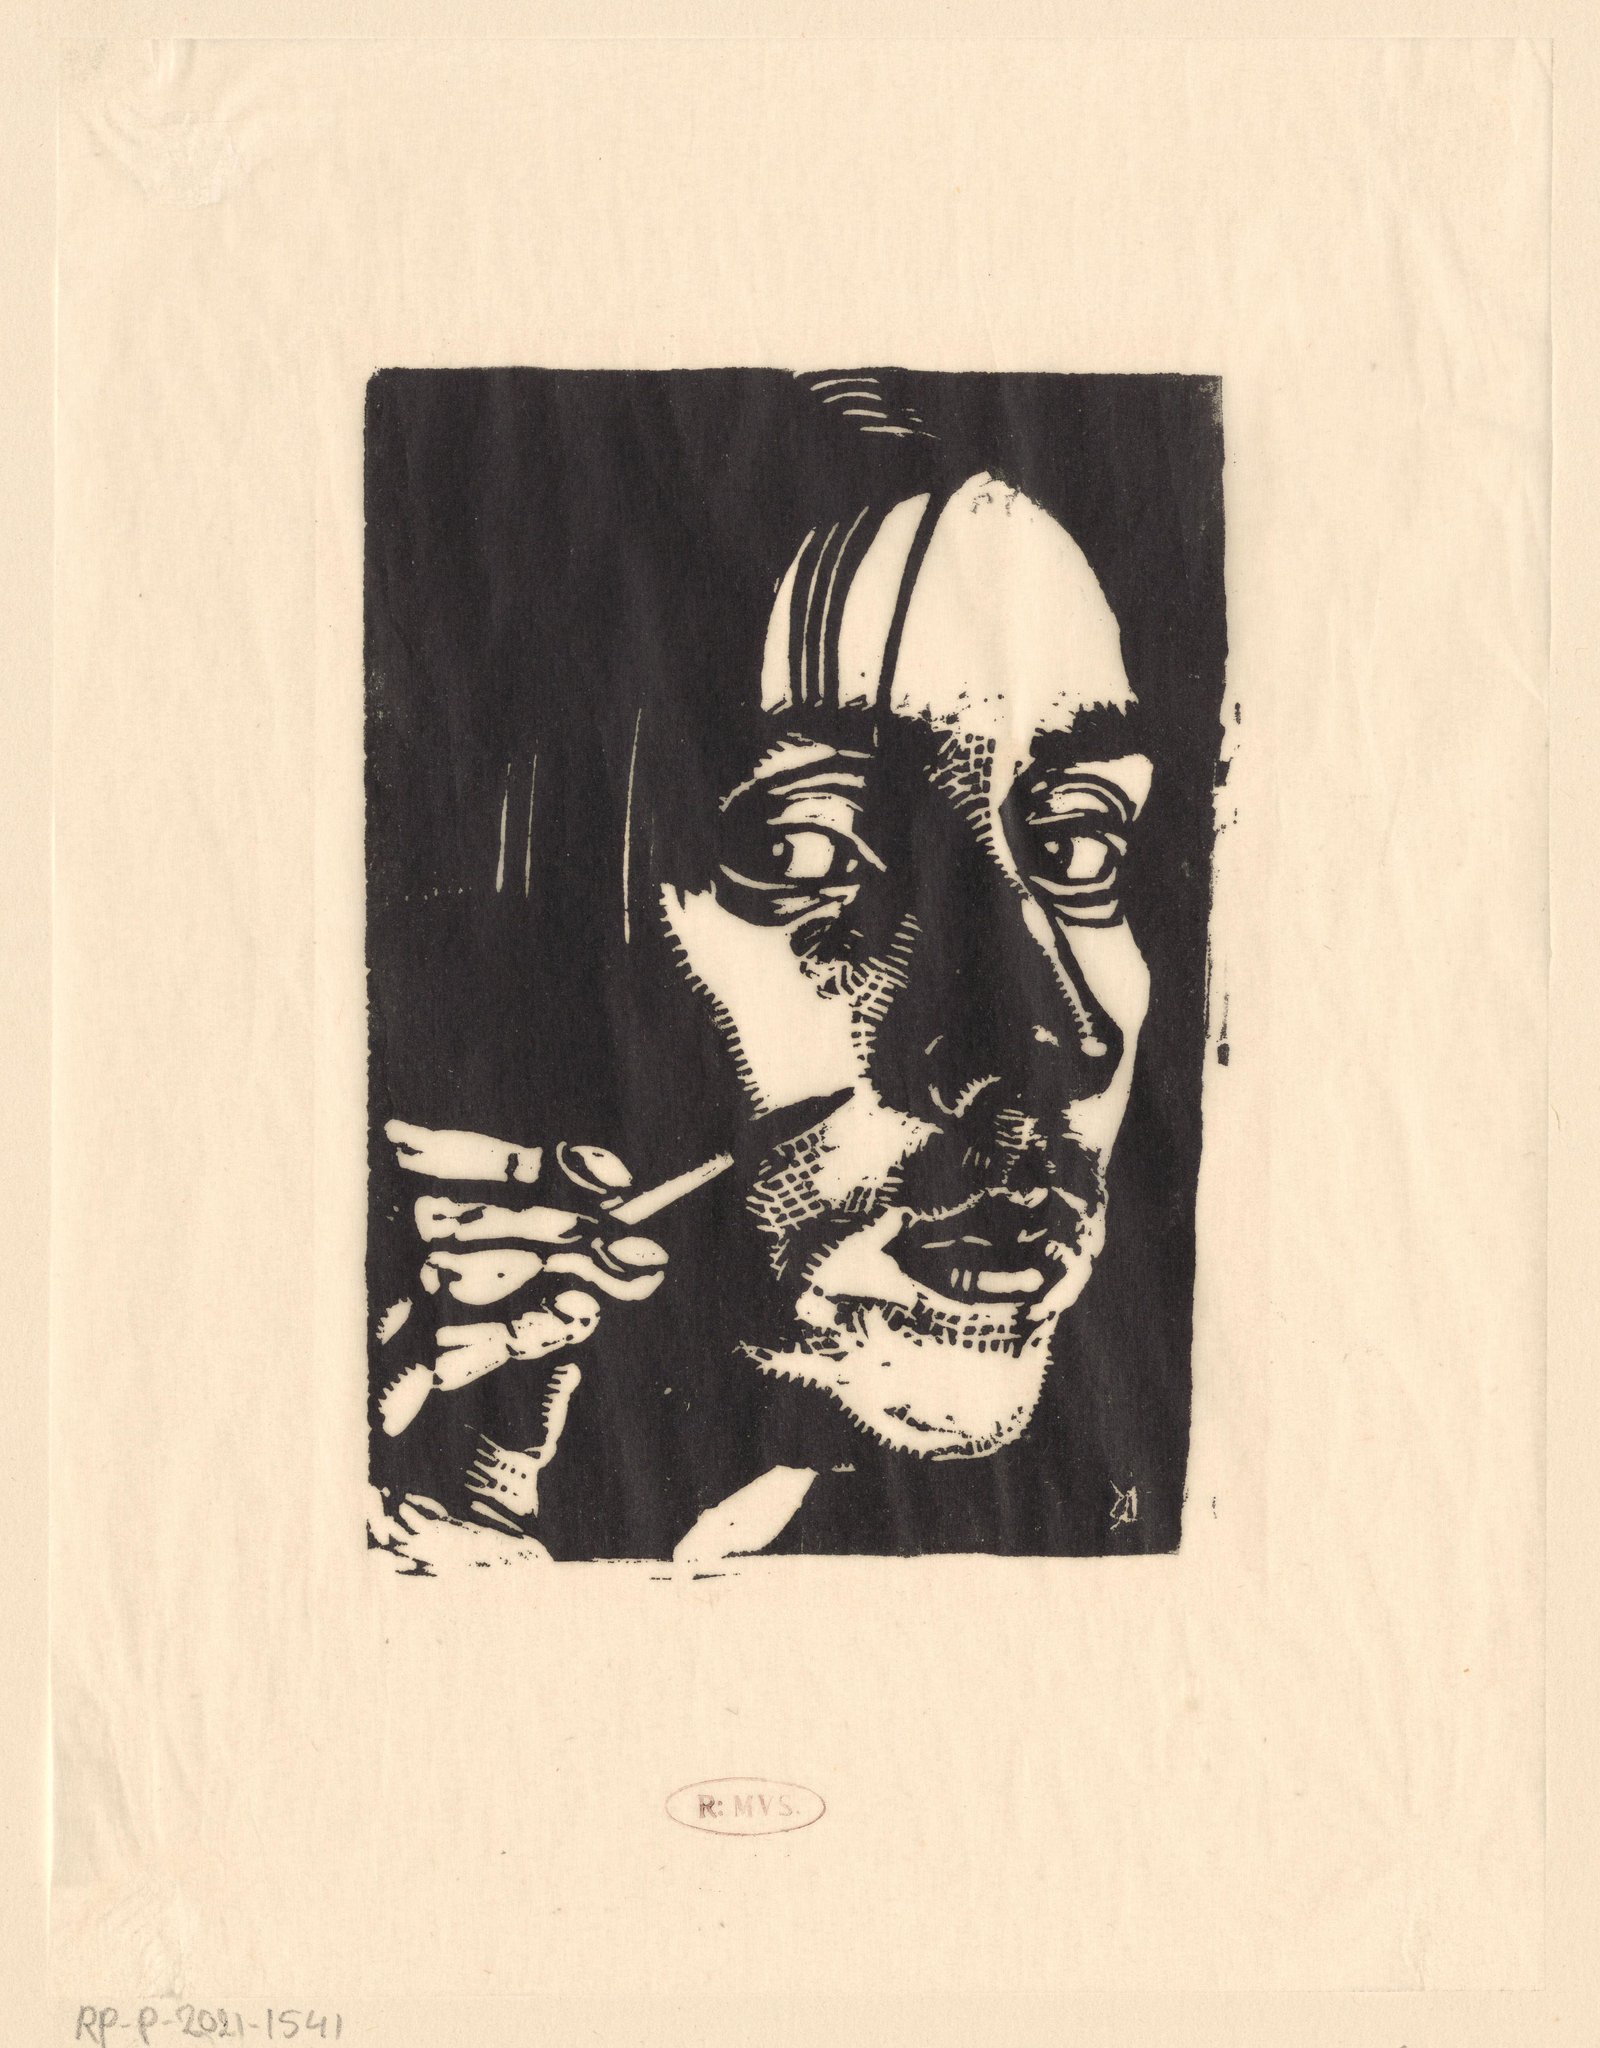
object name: print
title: Zelfportret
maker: dick ket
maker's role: draughtsman, print maker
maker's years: 1902-1940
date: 1912-1940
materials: paper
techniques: linocut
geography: bennekom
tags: den helder, print maker, draughtsman, dick ket, historical persons, portrait, self-portrait of painter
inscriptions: collector's mark: Lugt 2228